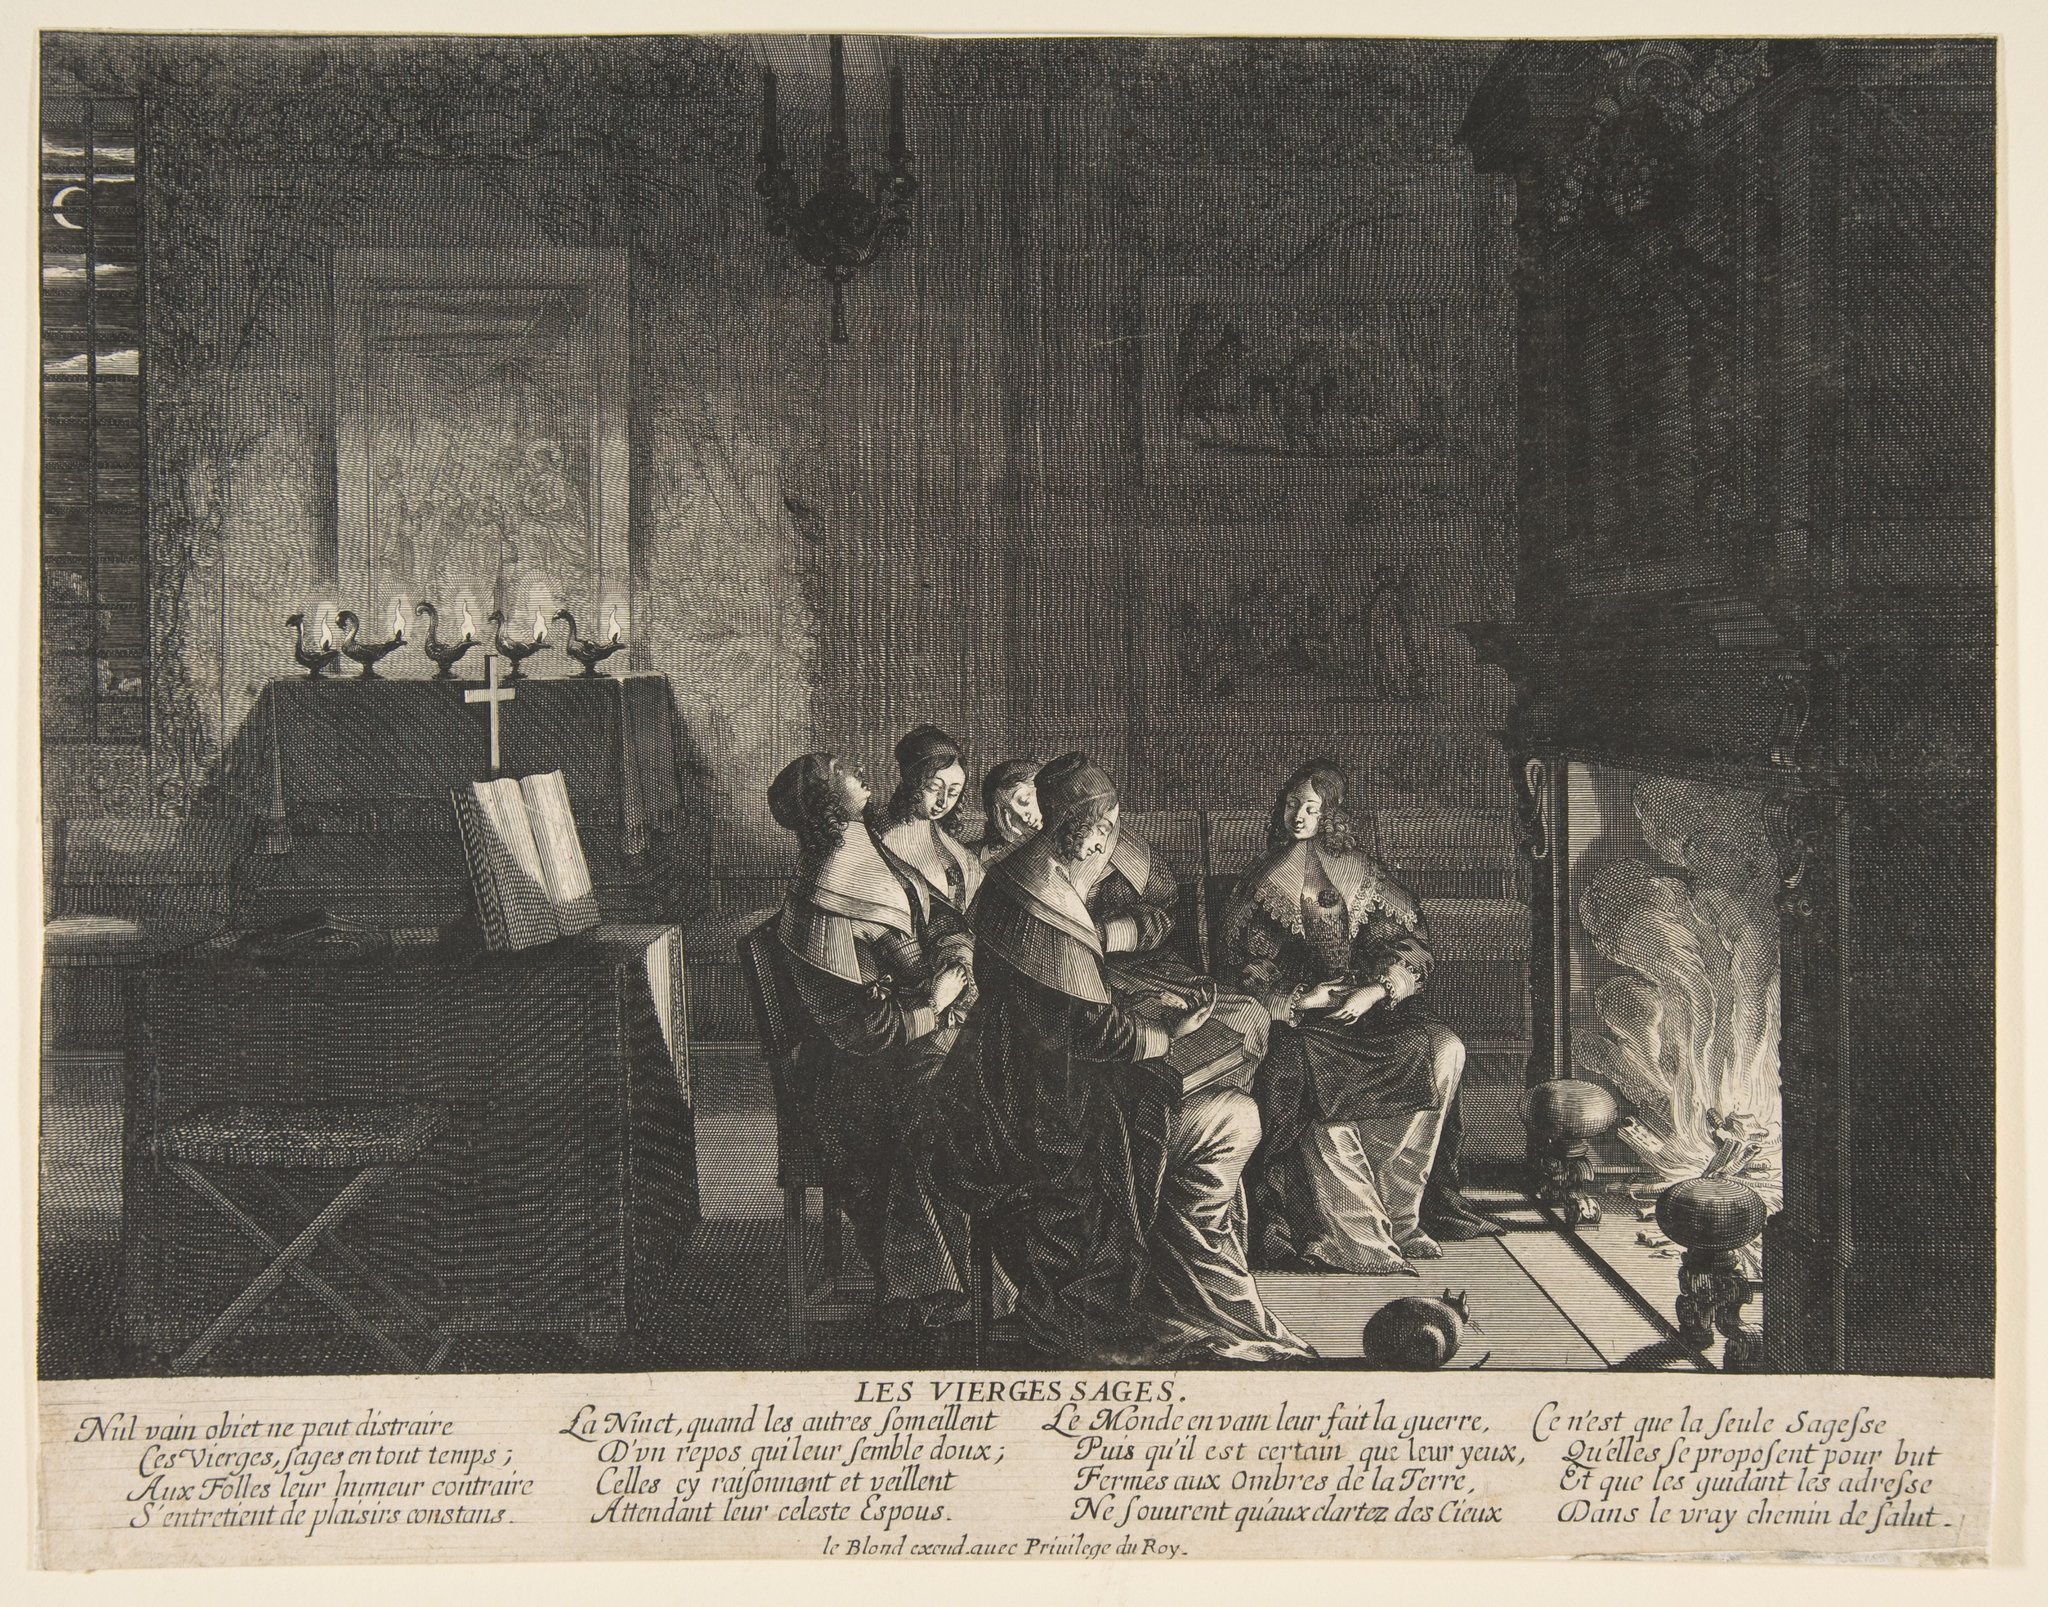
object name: print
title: The Wise Virgins Resting Whilst Awaiting the Arrival of The Husband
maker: abraham bosse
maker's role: artist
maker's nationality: french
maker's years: 1602-1676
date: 1635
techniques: etching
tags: women,virgin mary,cross